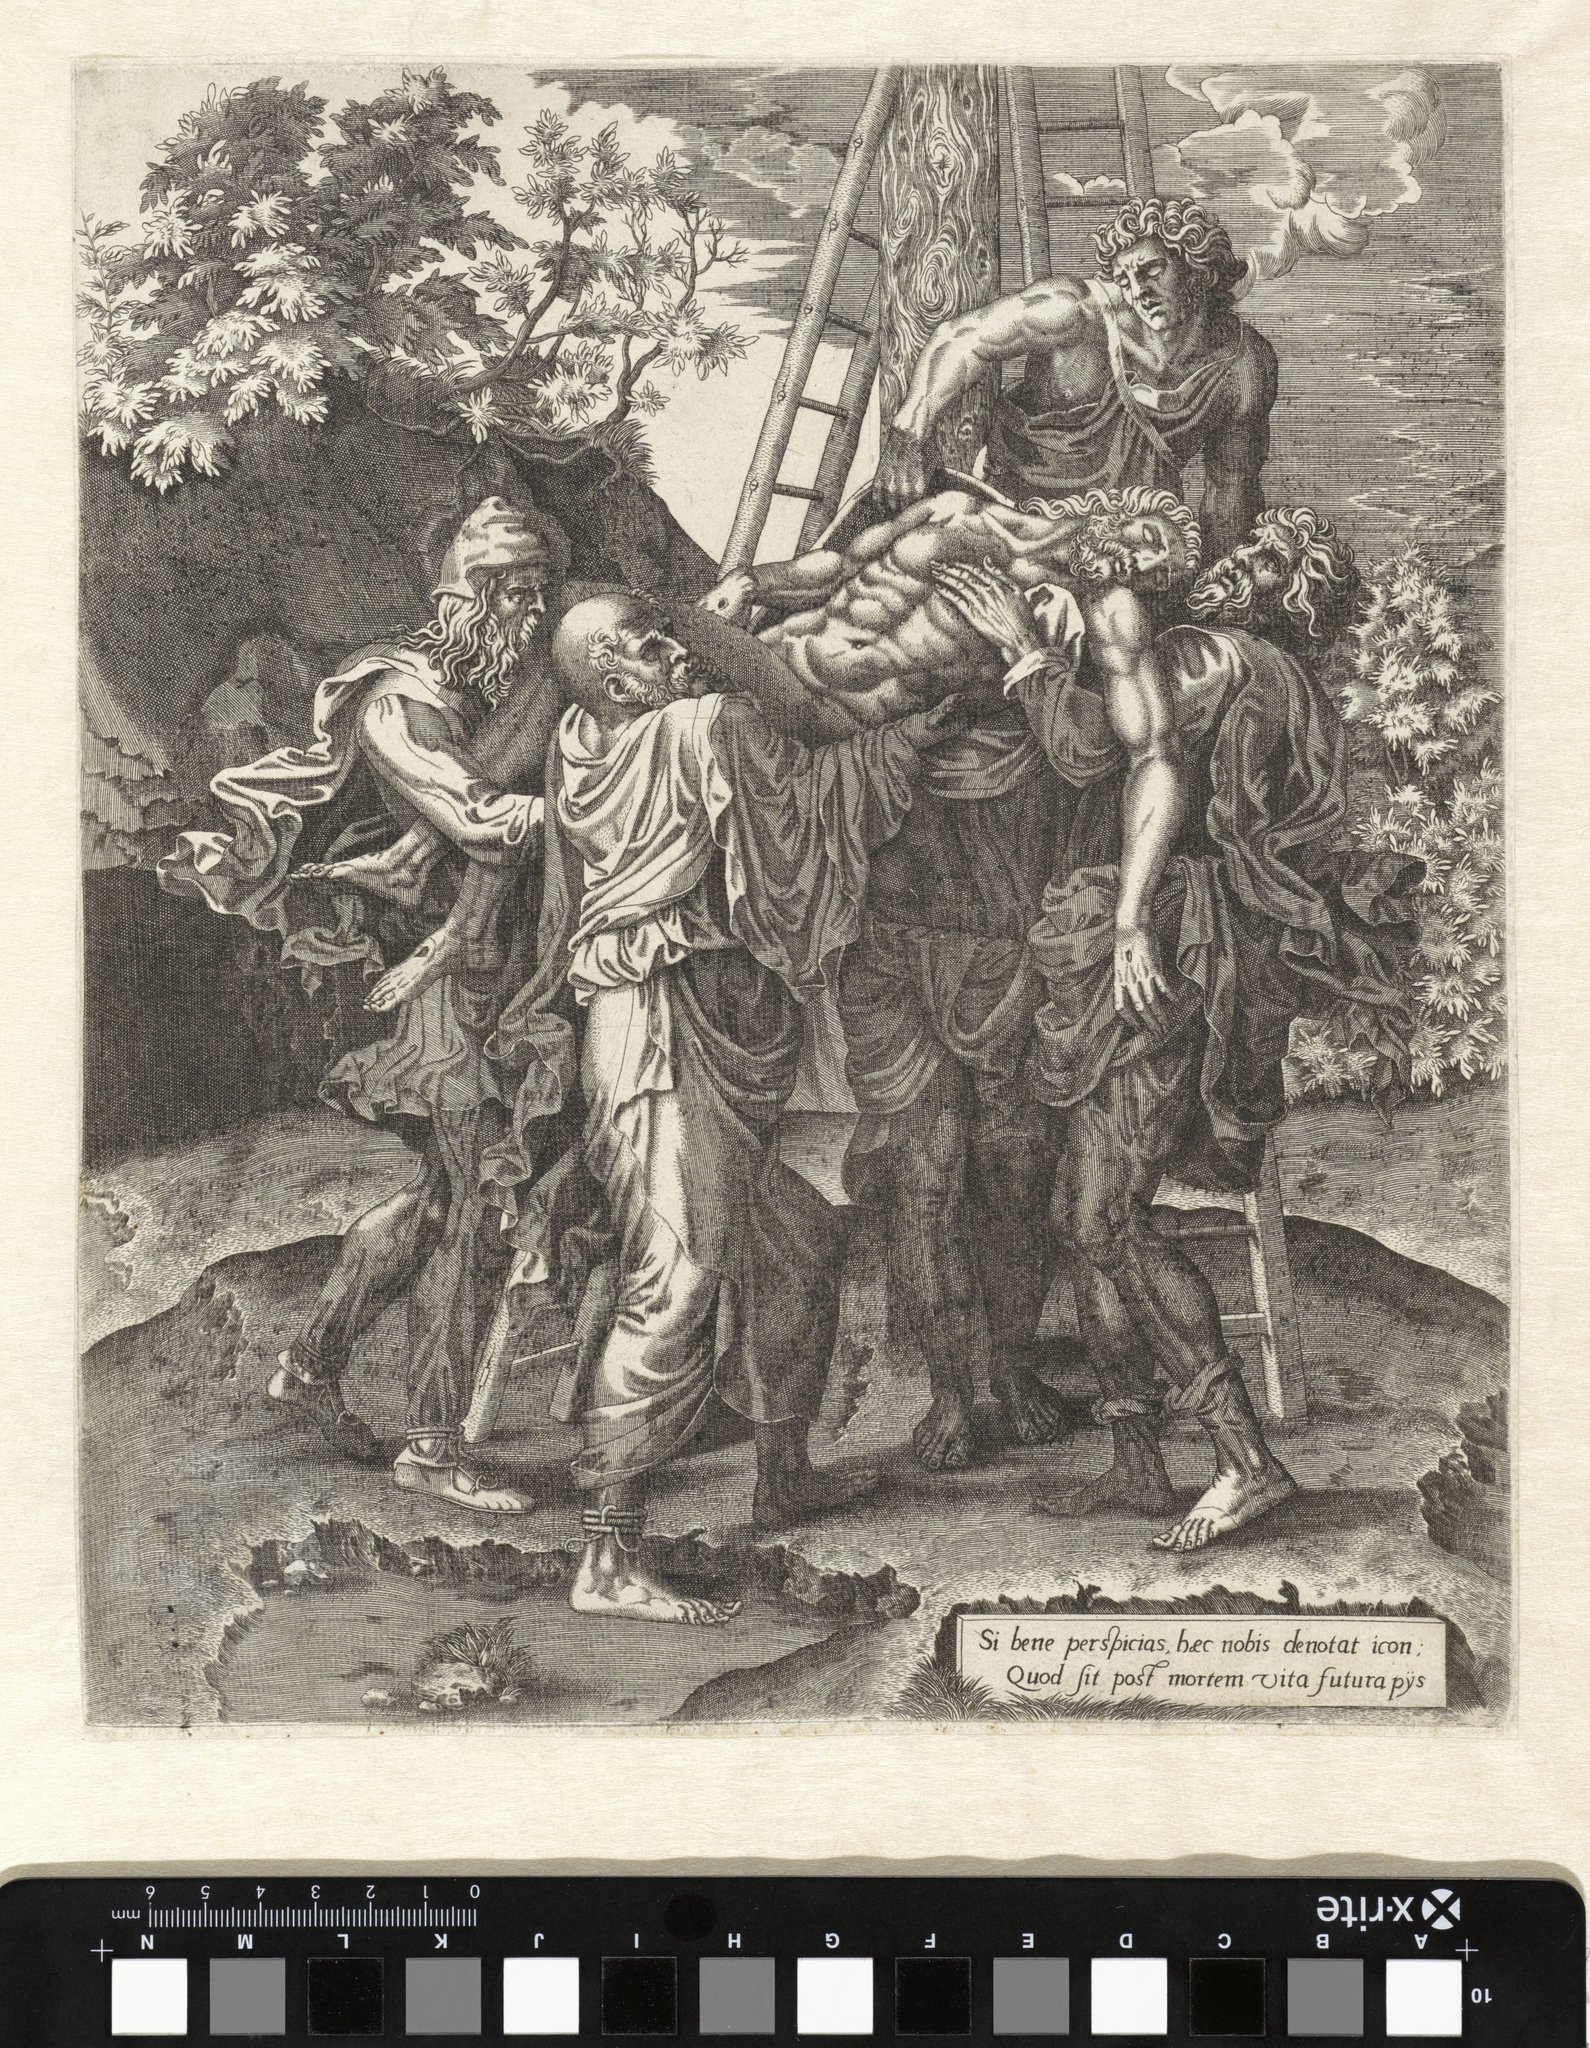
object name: print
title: Kruisafneming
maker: Anonymous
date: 1553-1616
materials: paper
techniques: engraving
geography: liège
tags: descent from the cross: christ is taken down from the cross, usually by nicodemus and joseph of arimathaea who are standing on the ladders (both arms of christ detached)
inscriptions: collector's mark: Lugt 2760, collector's mark: Lugt 2228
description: Het lichaam van Christus wordt door vier mannen, onder wie Nikodemus en Jozef van Arimatea, van het kruis afgehaald. Tegen het kruis staan twee ladders. Rechtsonder een tweeregelig onderschrift in het Latijn.